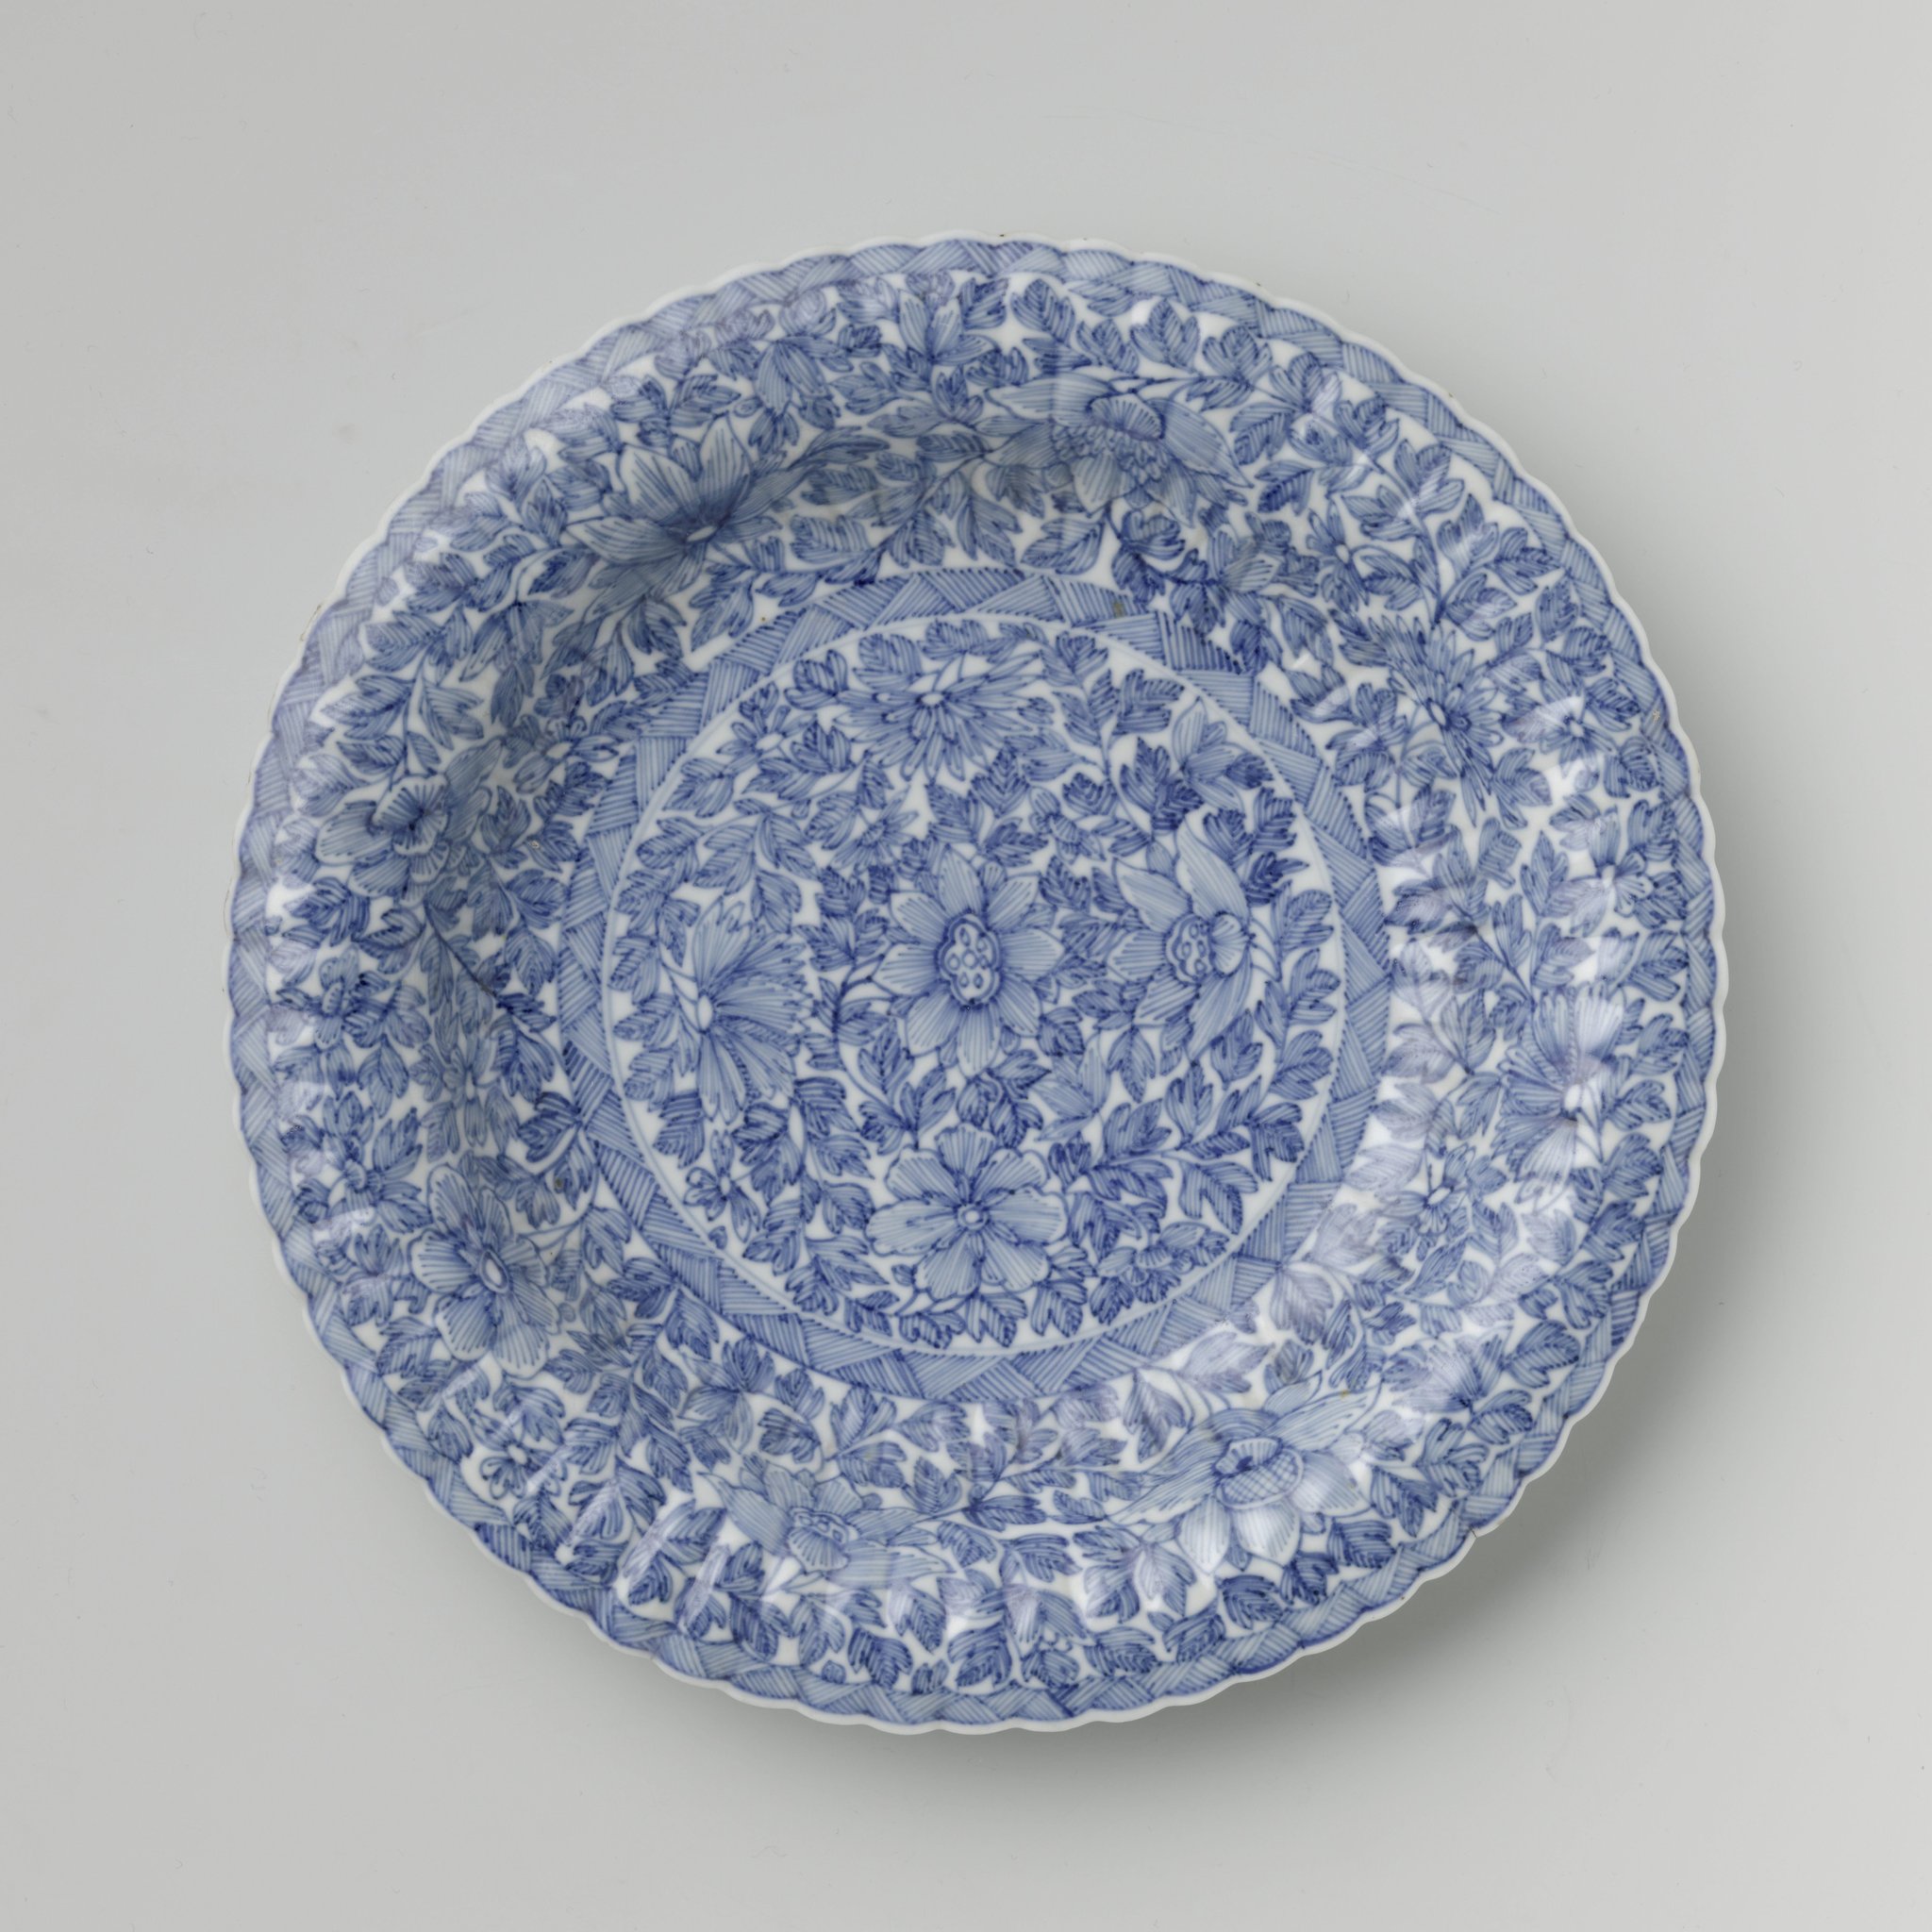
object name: plate dish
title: Plate with fluted sides and continuous flower pattern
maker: Anonymous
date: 1700-1724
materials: cobalt, glaze, paint, porcelain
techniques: firing, forming, turning, vitrification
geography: china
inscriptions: mark